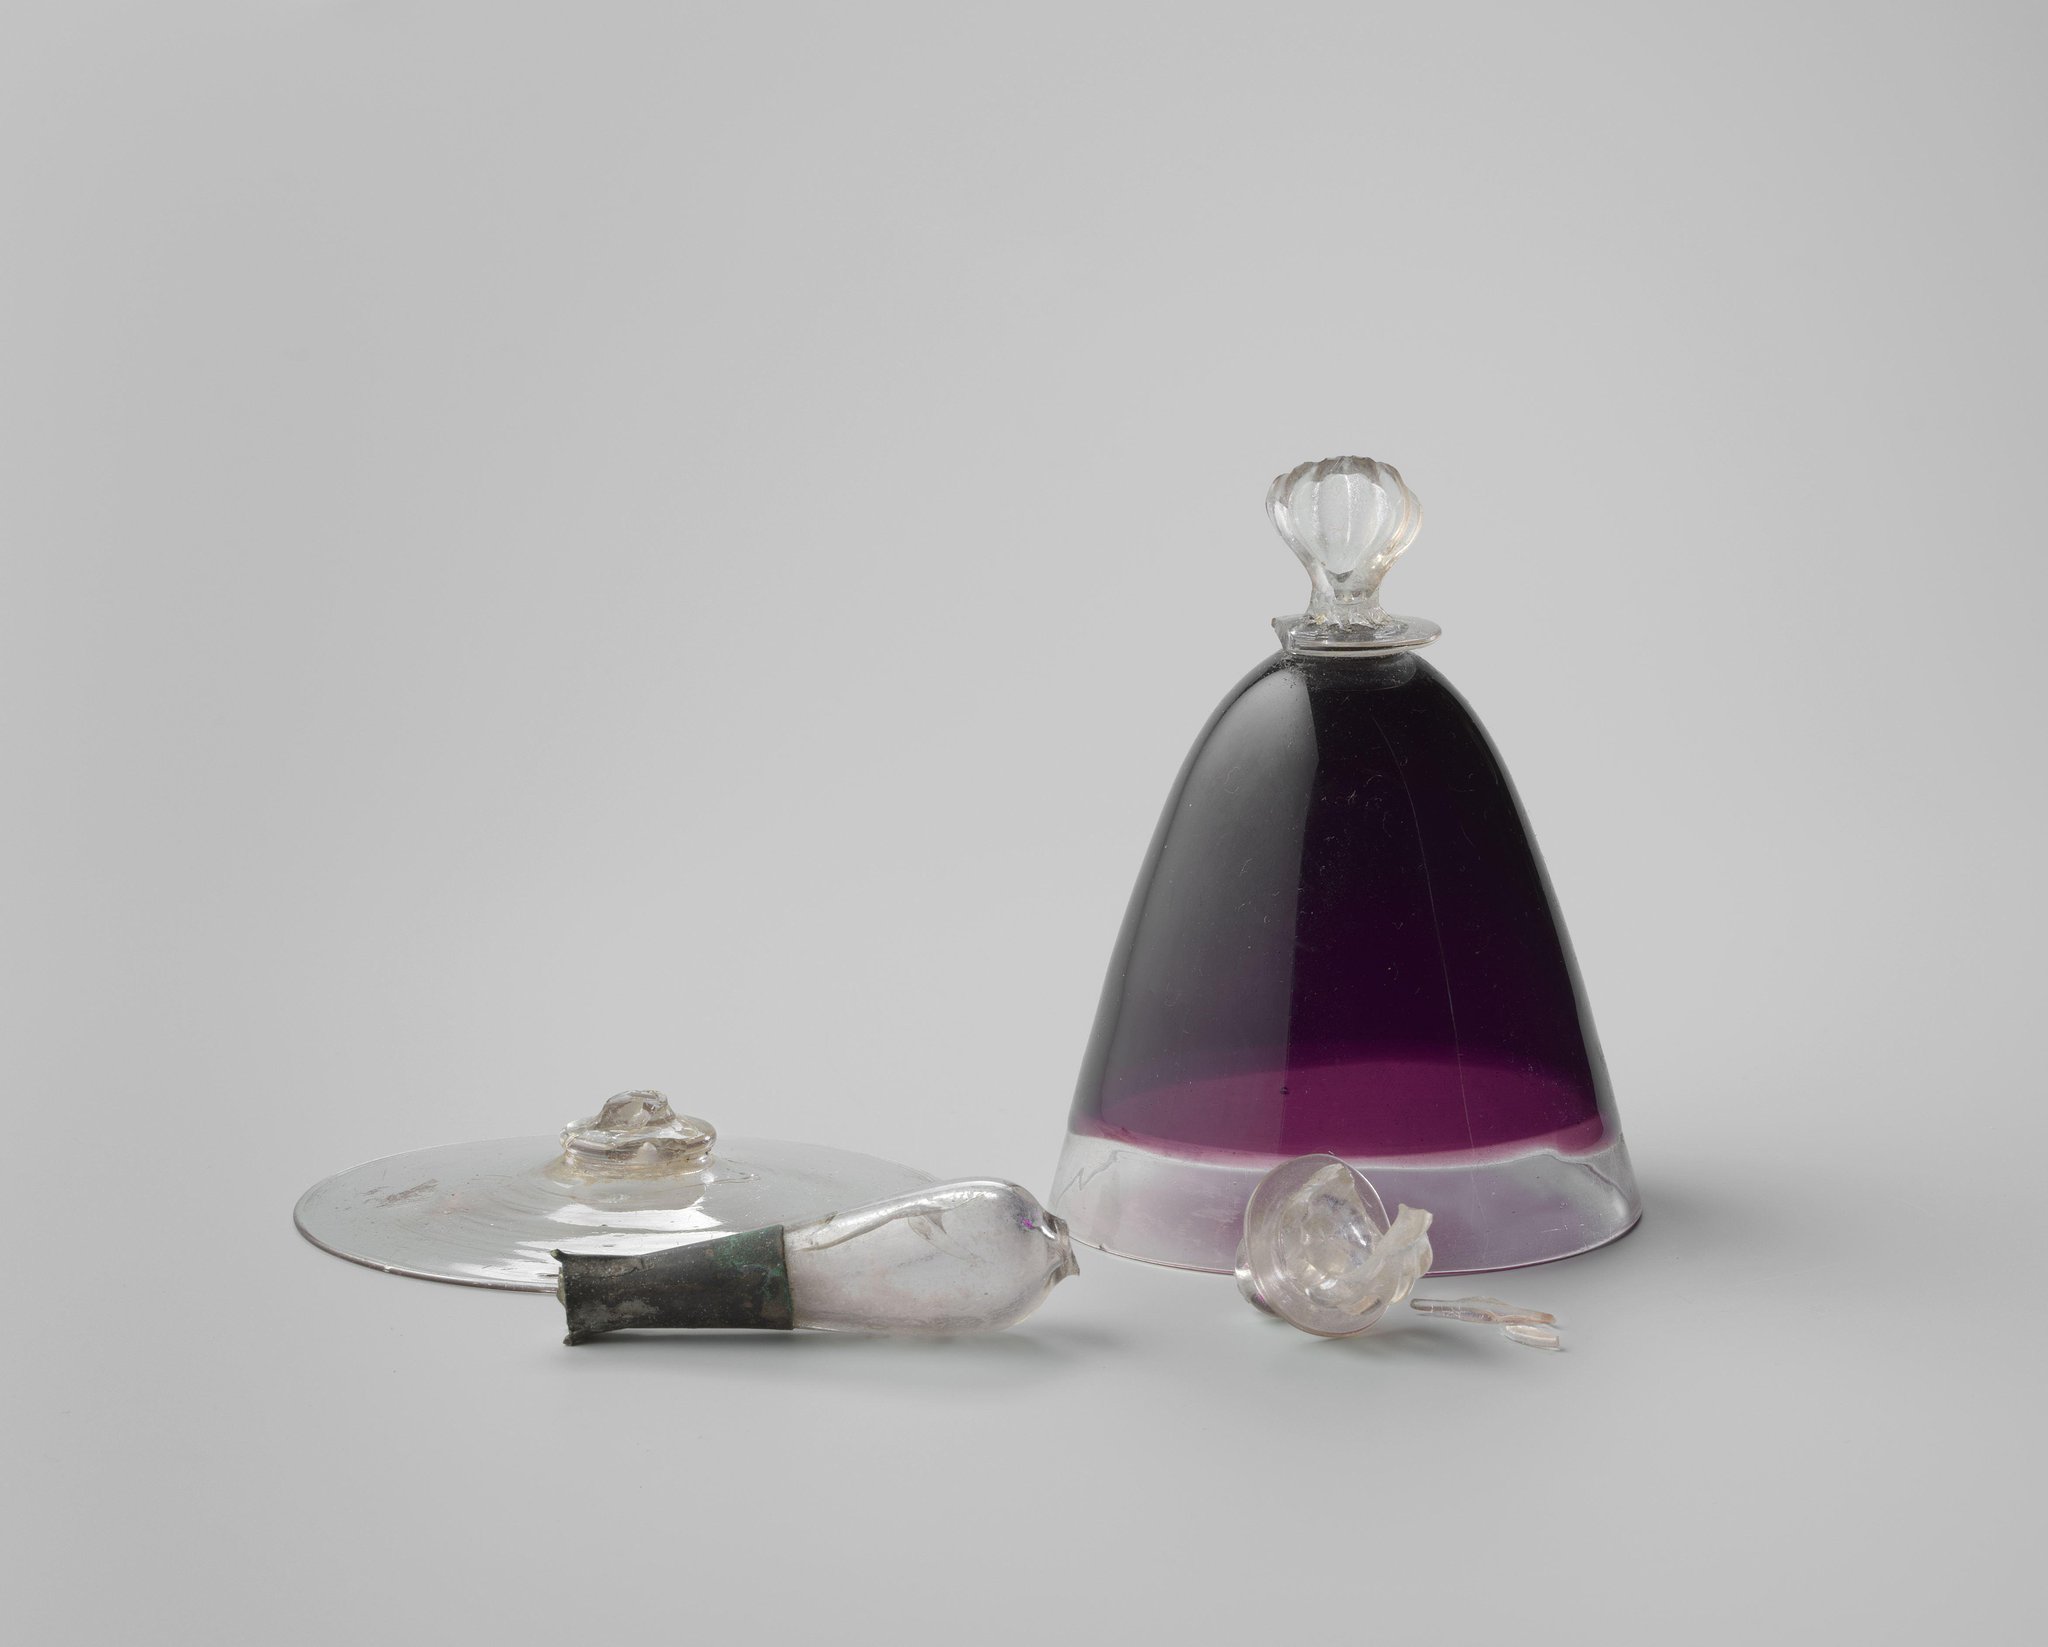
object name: goblet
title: Kelkglas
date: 1700-1800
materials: glass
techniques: glassblowing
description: Conische, licht gewelfde voet. Rechte stam overgaande in een trompetvormige kelk, gedeeltelijk paars van kleur.